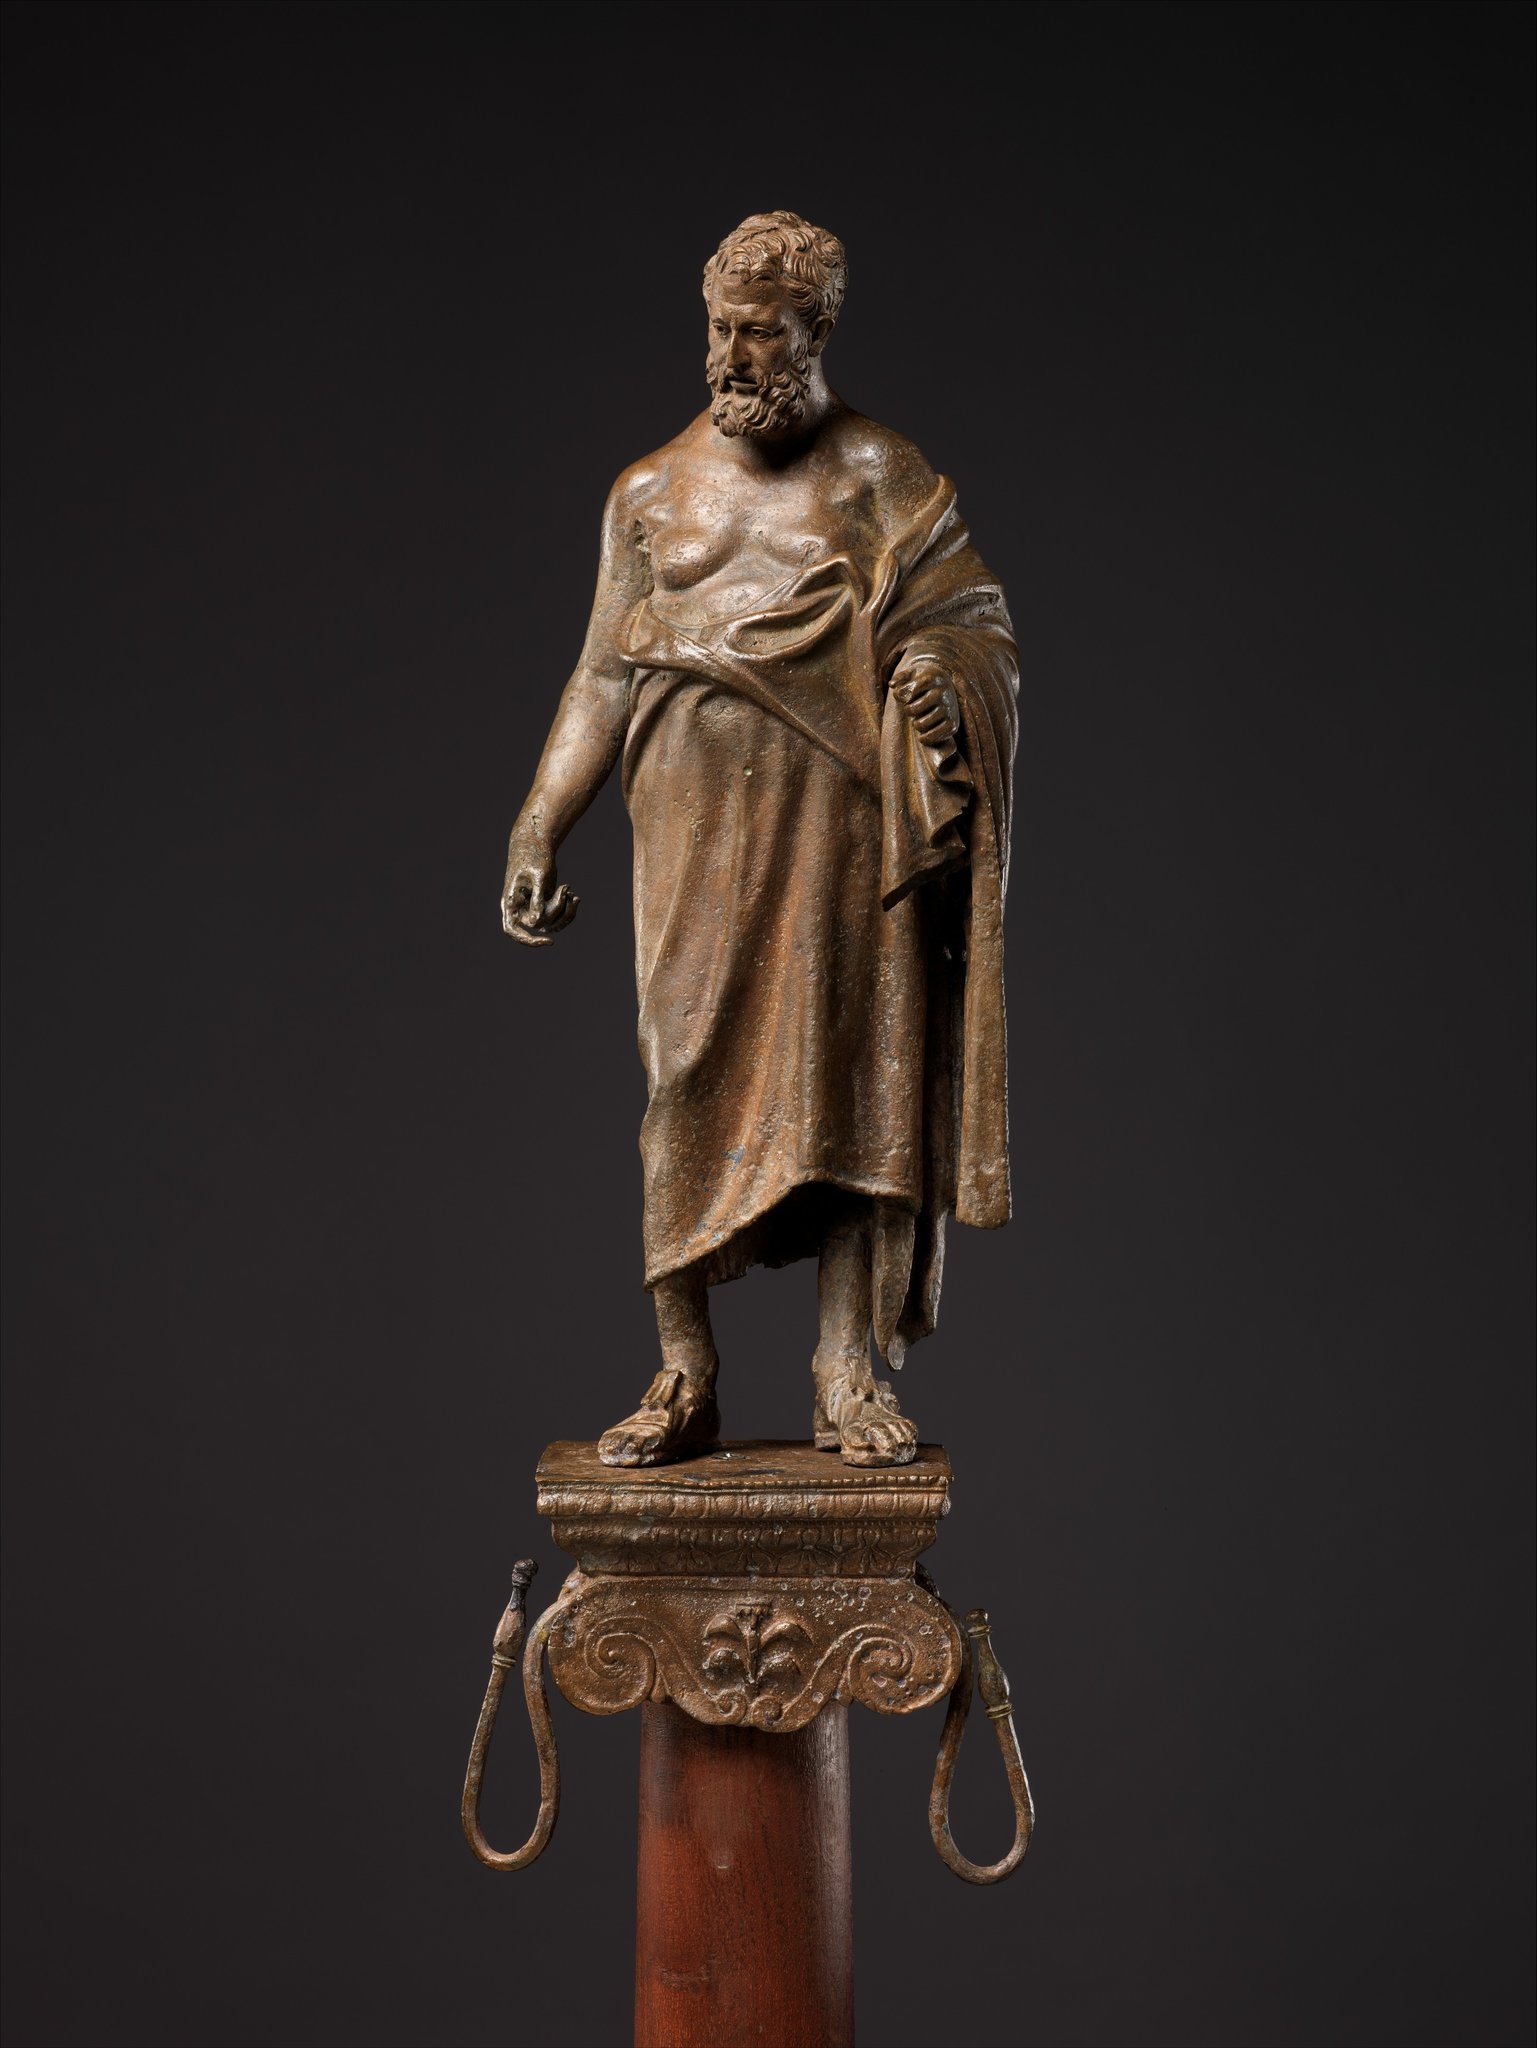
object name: statuette of philosopher on lamp stand, hermarchos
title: Bronze statuette of a philosopher on a lamp stand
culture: roman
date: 34-1 BCE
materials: bronze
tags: men,philosophers